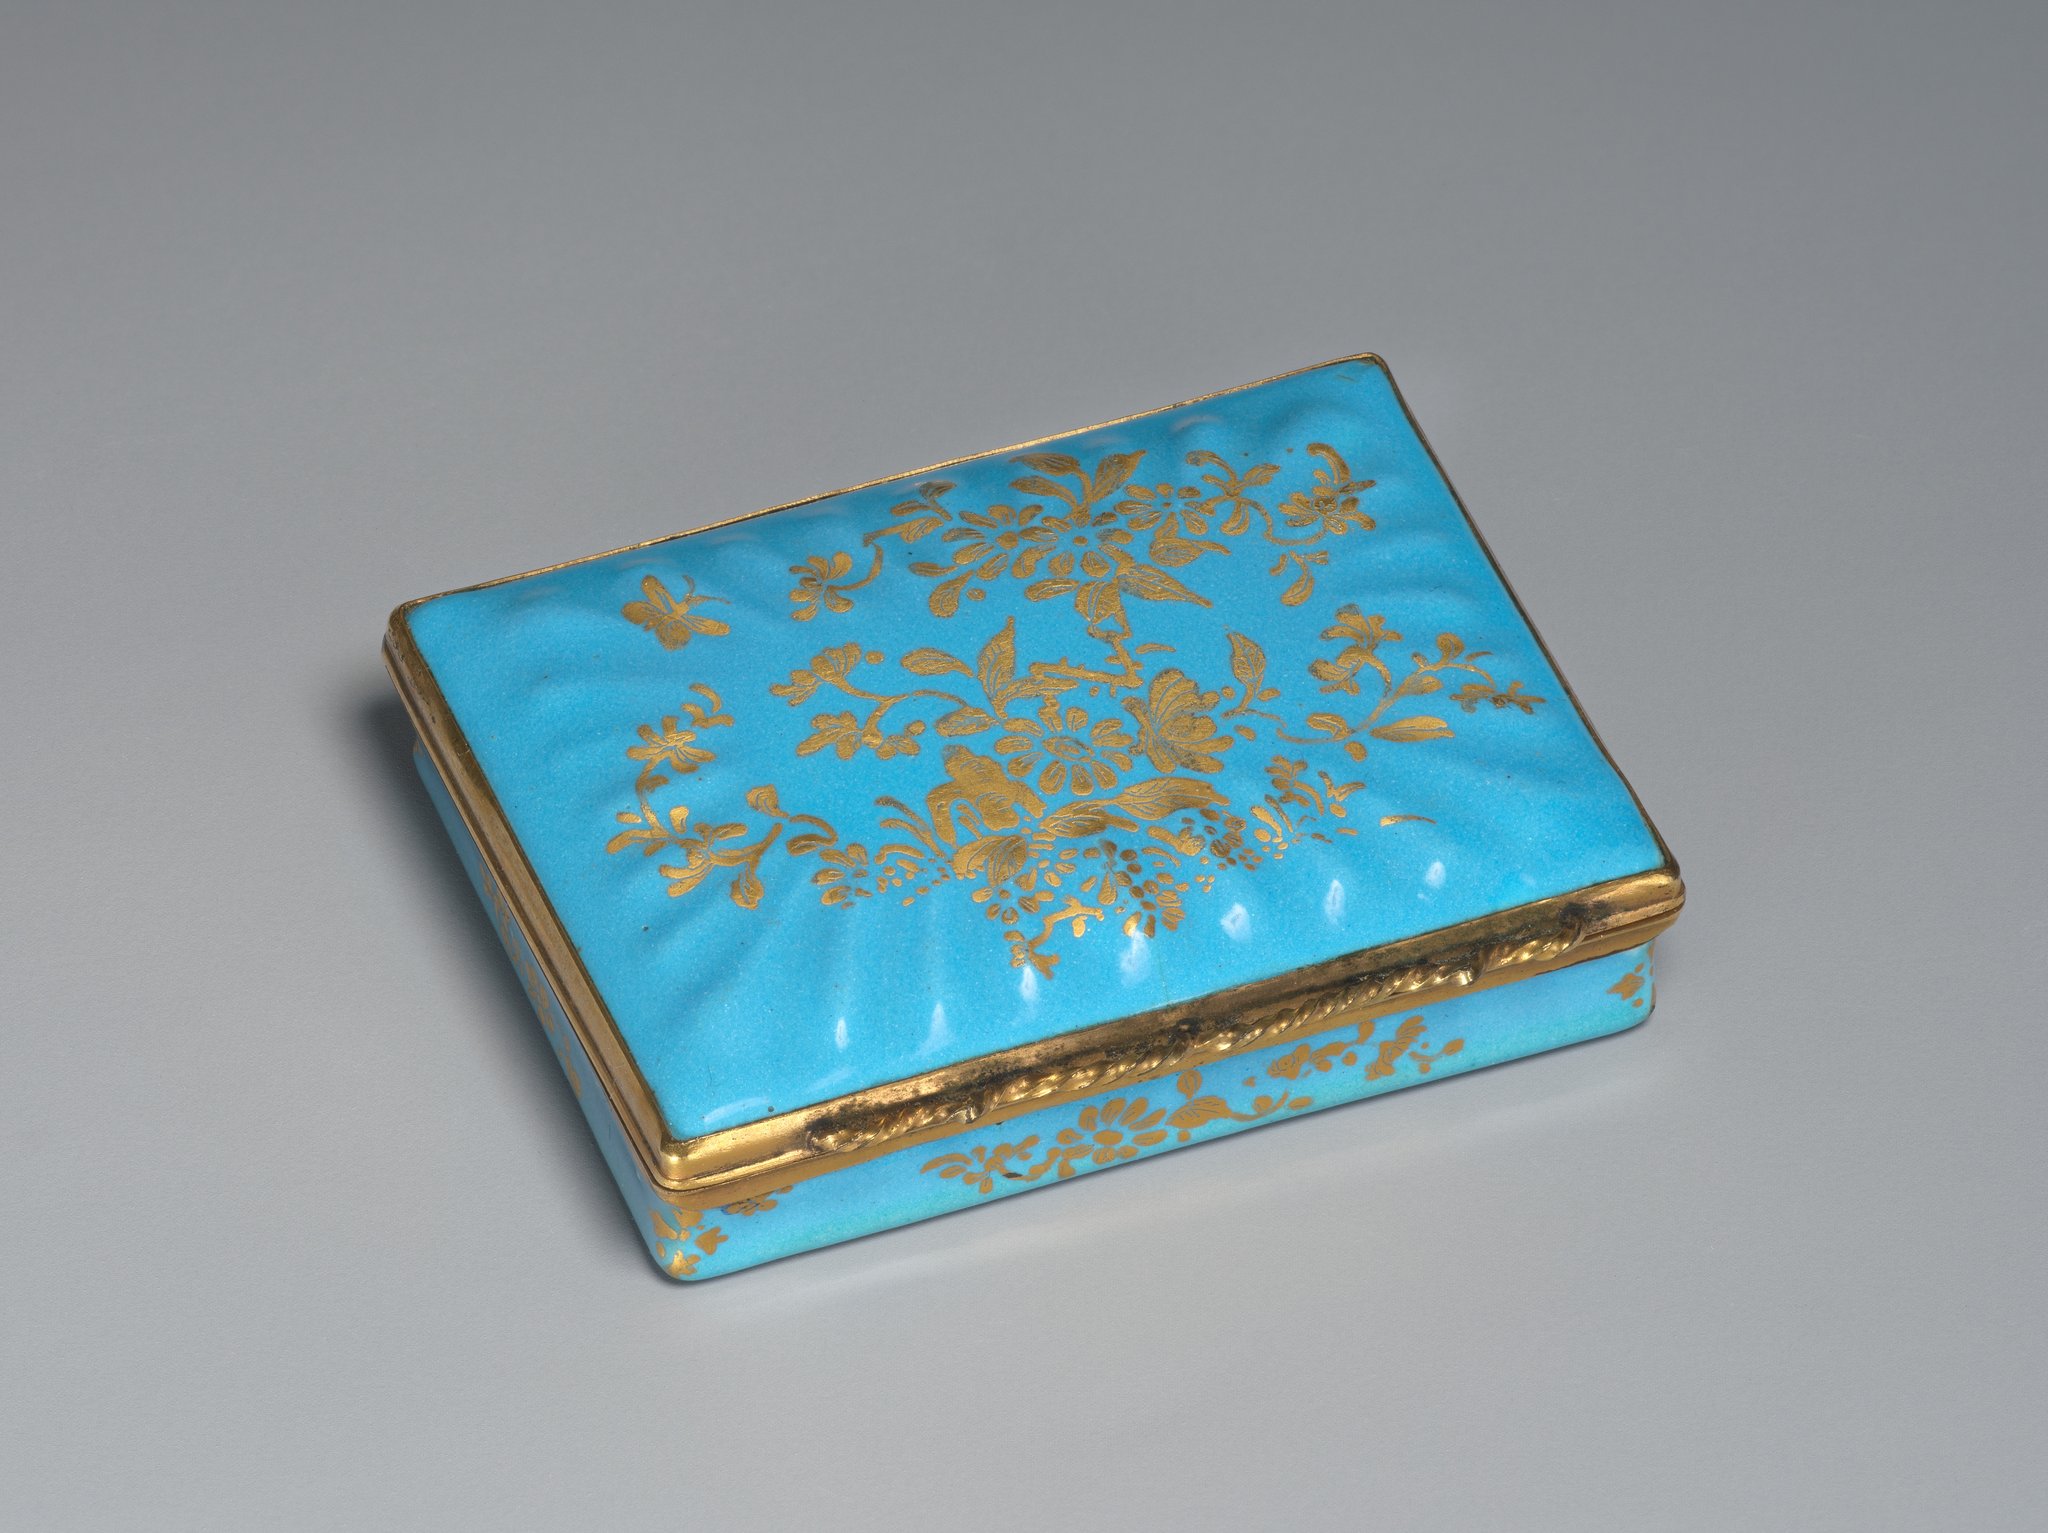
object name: patch box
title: Patch box inscribed “Voyez et Souvenez” [See and Remember]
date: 1750-1759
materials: copper, enamel, glass